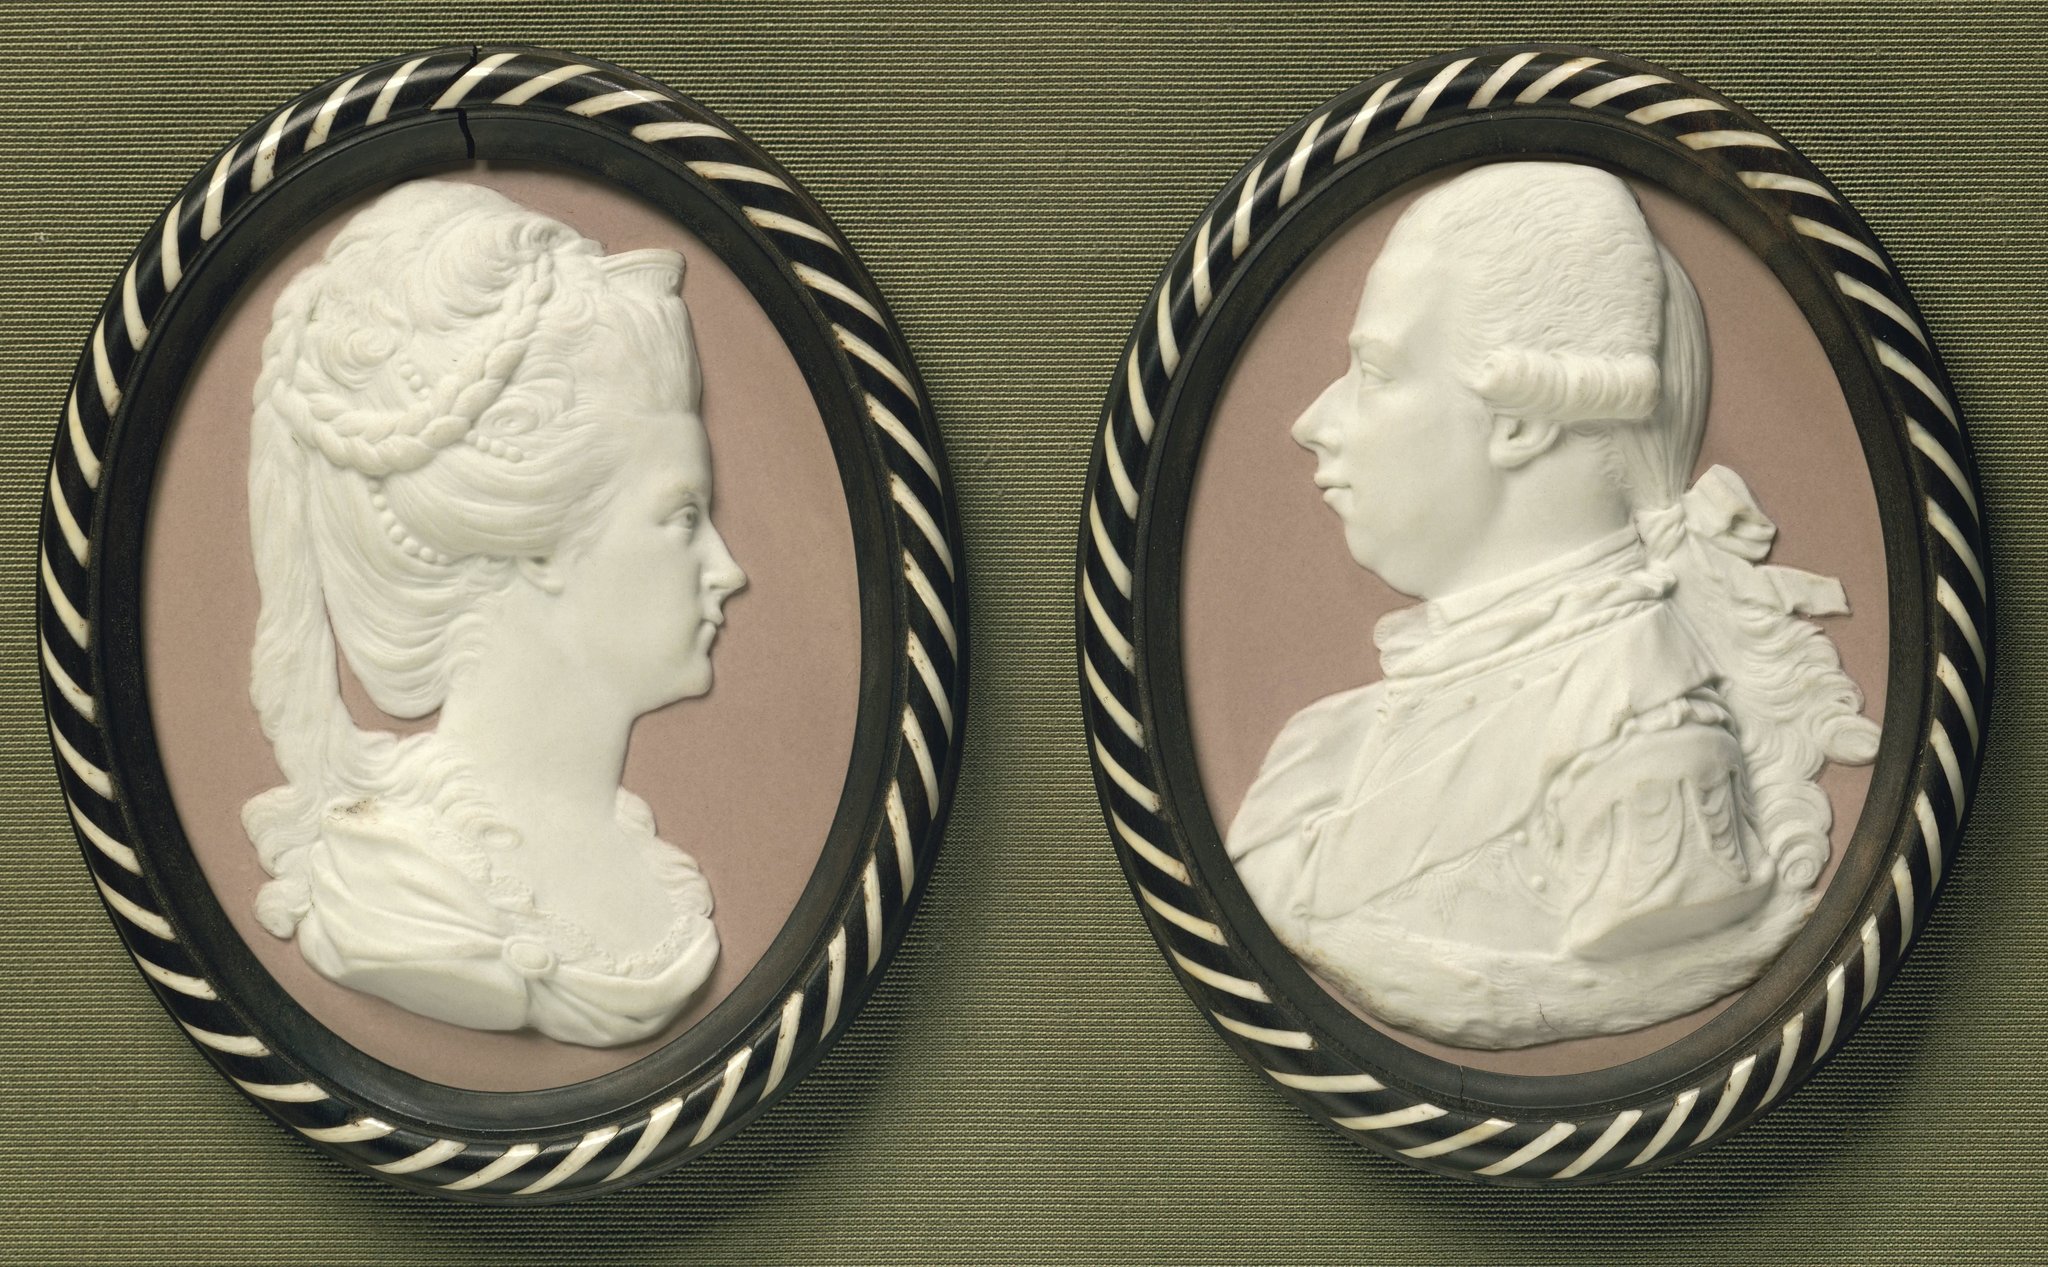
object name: portretmedaillon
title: Willem V van Oranje-nassau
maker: johann heinrich schepp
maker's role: sculptor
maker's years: 1736-1811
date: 1782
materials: bone, wood, porcelain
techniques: cutting, firing, inlay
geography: etruria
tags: the hague, william v (prince of orange), historical persons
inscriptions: mark: ‘WEDGEWOOD’